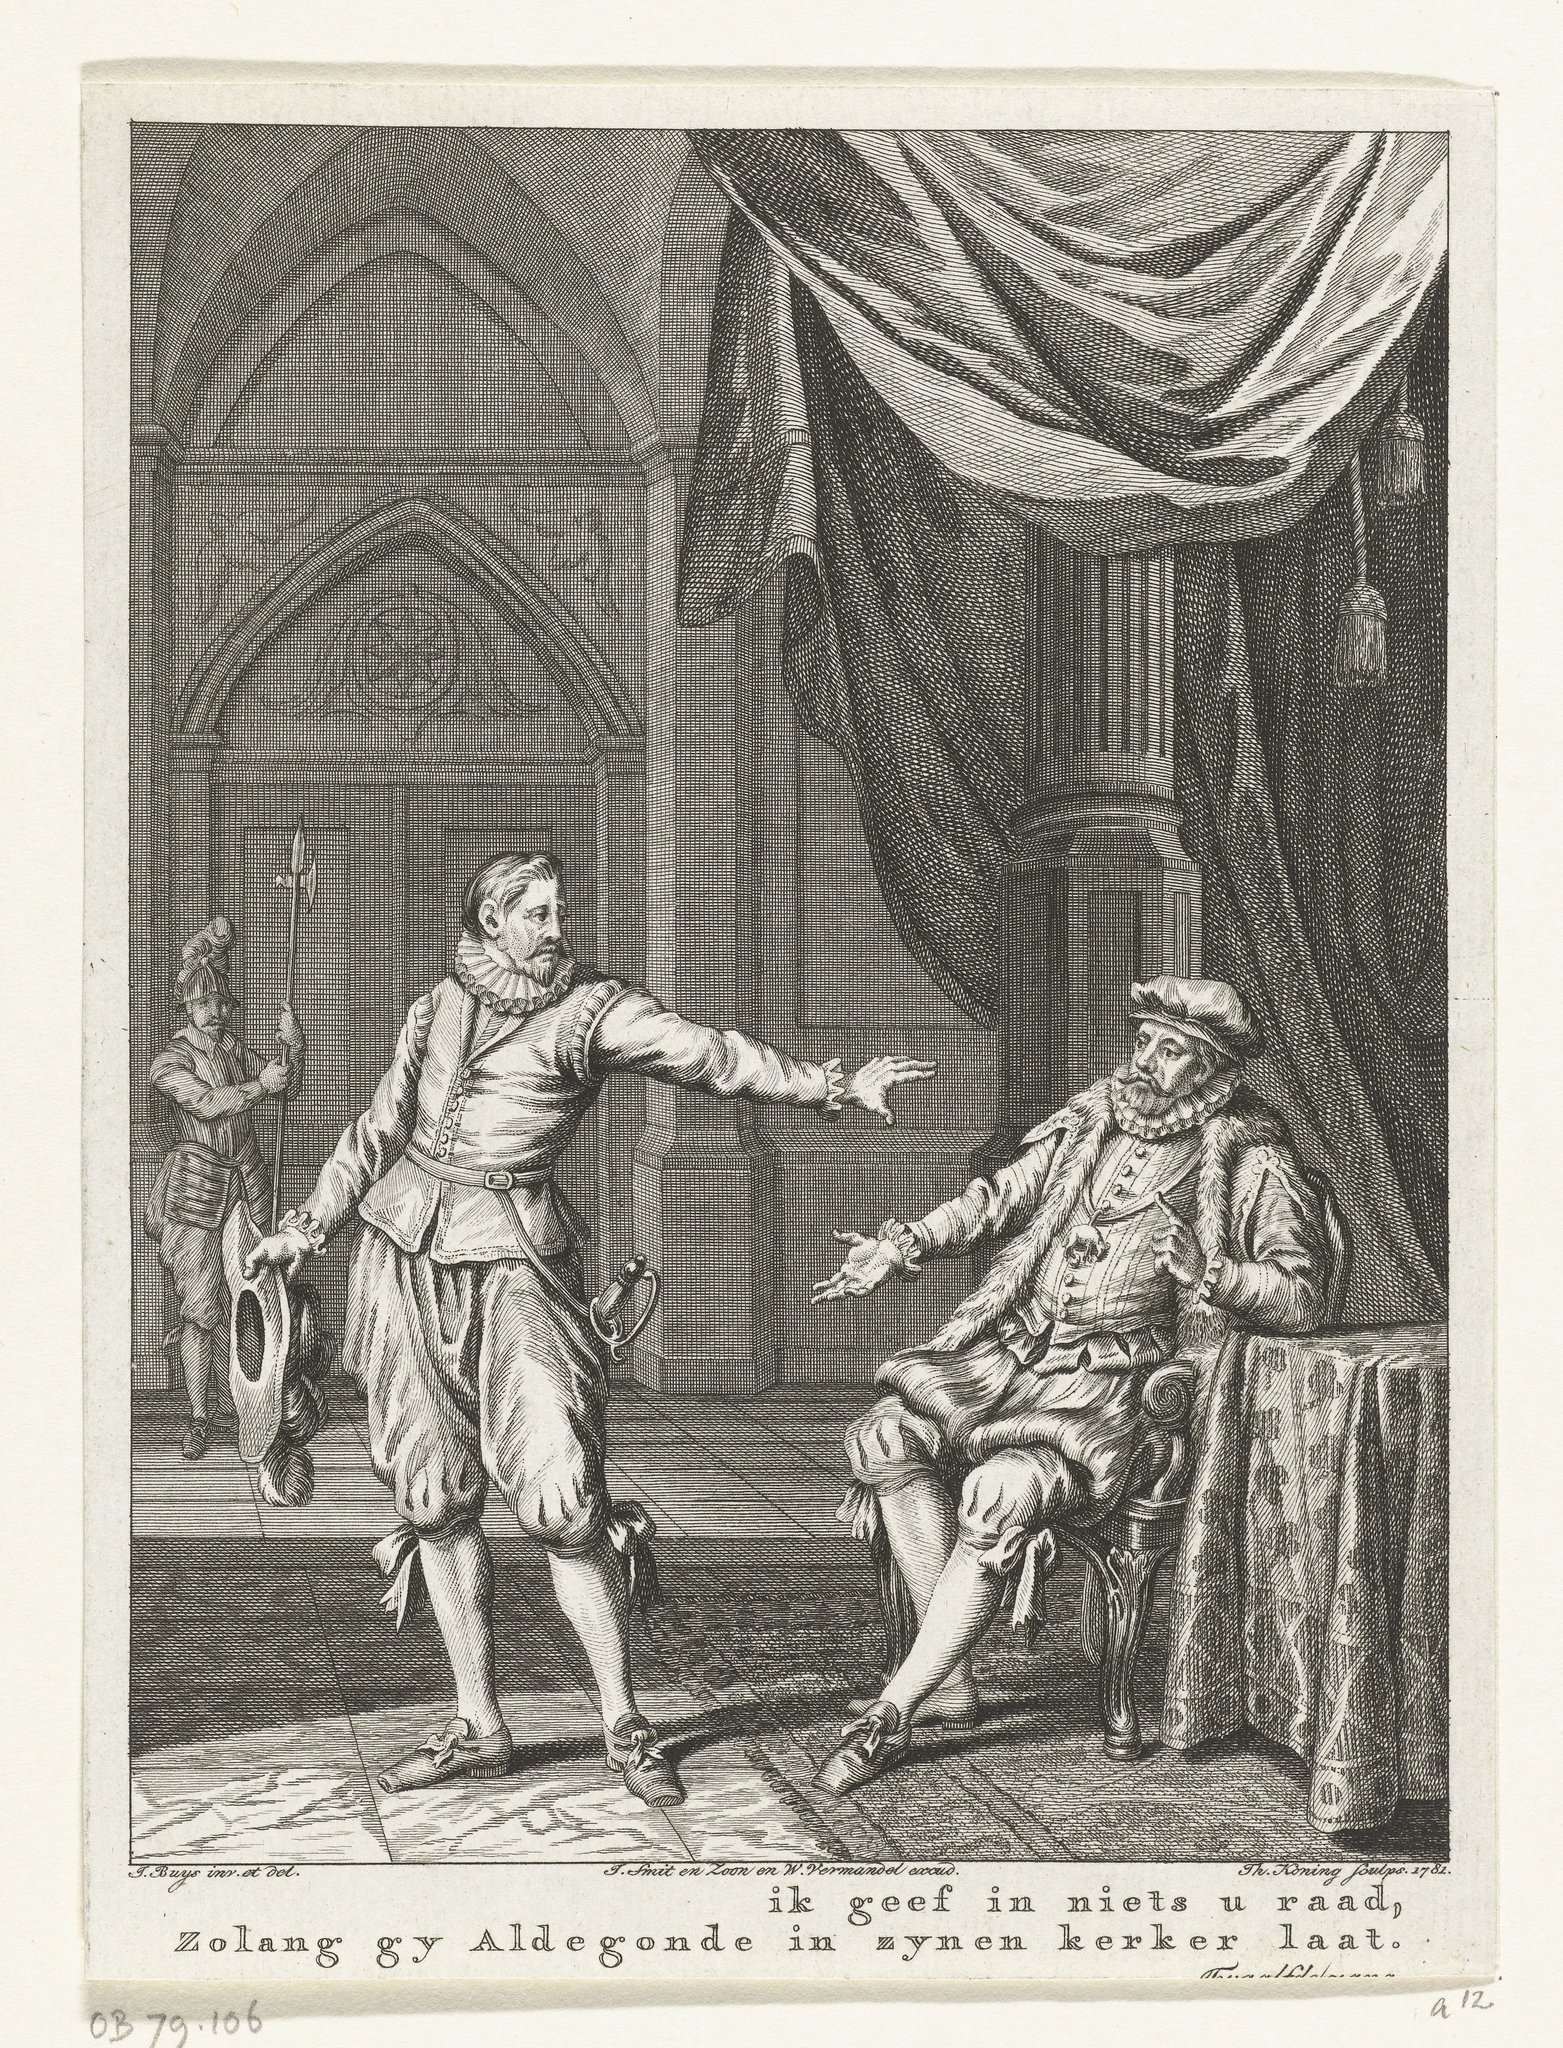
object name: print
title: ik geef in niets u raad, / Zolang gy Aldegonde in mynen kerker laat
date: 1781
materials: paper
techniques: etching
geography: amsterdam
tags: mayor, luis de zúñiga y requesens, leiden, politician, filips van marnix van sint-aldegonde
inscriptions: date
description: Illustratie voor: J. Nomsz, Willem de eerste, of de grondlegging der Nederlandsche vryheid. : In vier en twintig zangen, Erven van David Klippink, Amsterdam 1779. Staat met de letter.